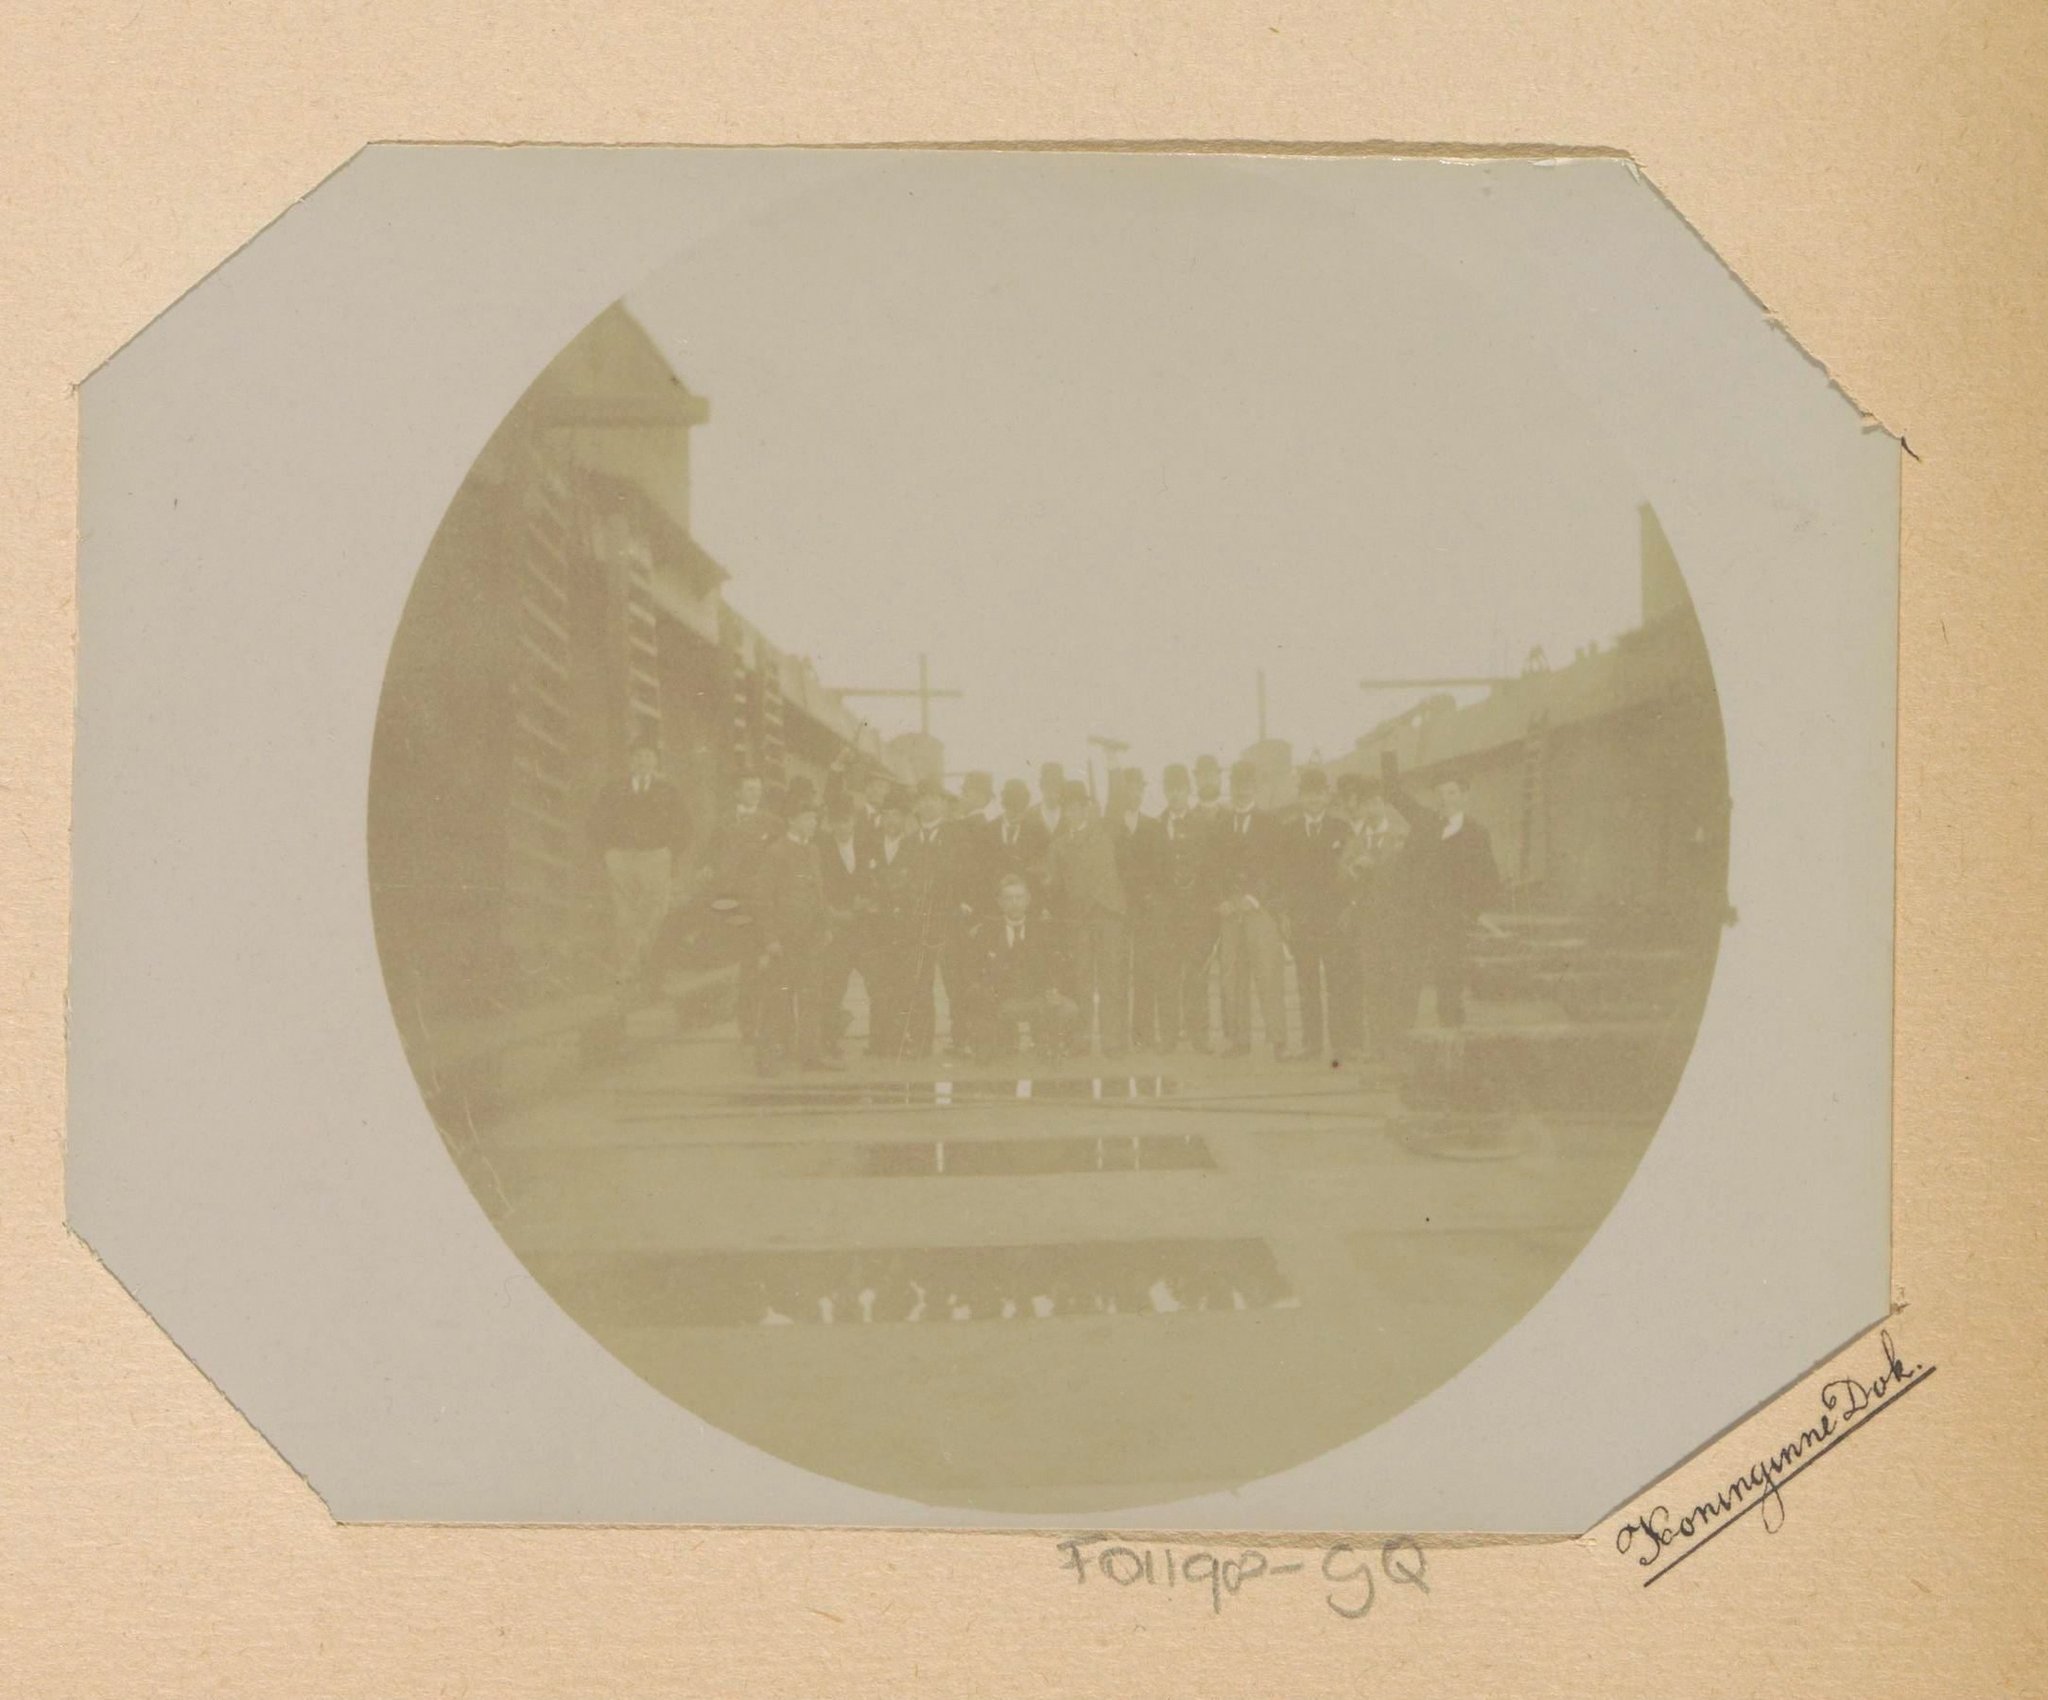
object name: photograph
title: Koninginne Dok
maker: willem frederik piek jr.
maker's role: fotograaf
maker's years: 1874-1954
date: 1889-1893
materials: paper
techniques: gelatin silver print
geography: amsterdam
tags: student life